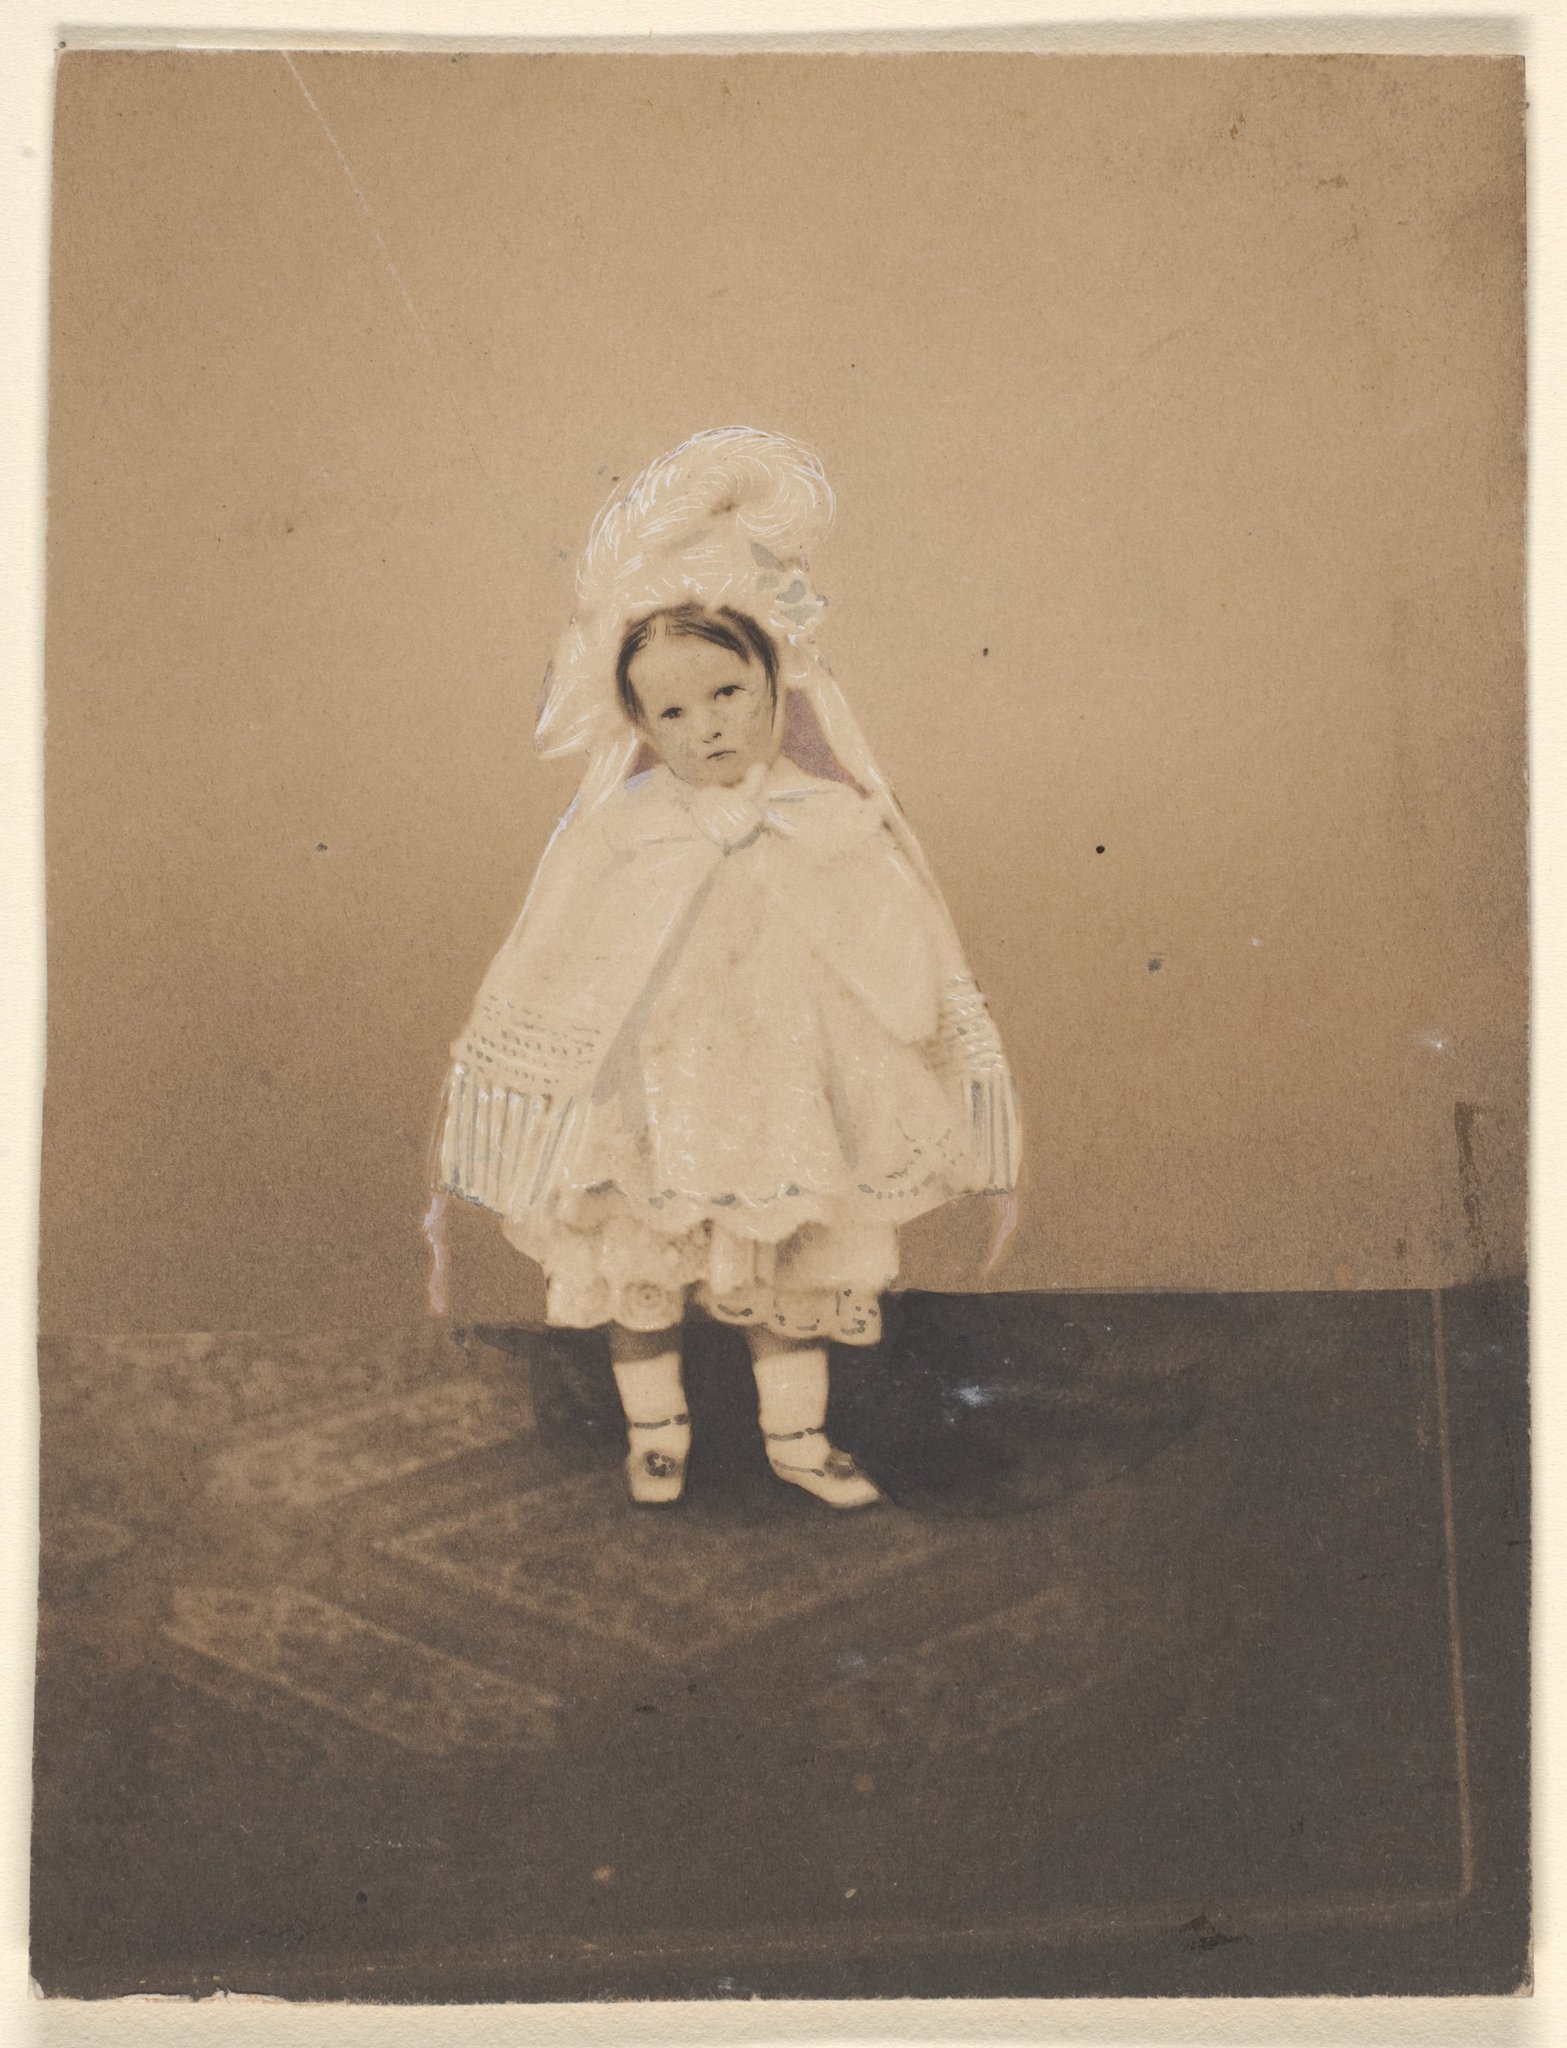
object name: photograph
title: La capuche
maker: pierre-louis pierson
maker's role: artist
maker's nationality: french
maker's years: 1822-1913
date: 1860-1869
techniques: albumen silver print, glass negative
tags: girls,portraits